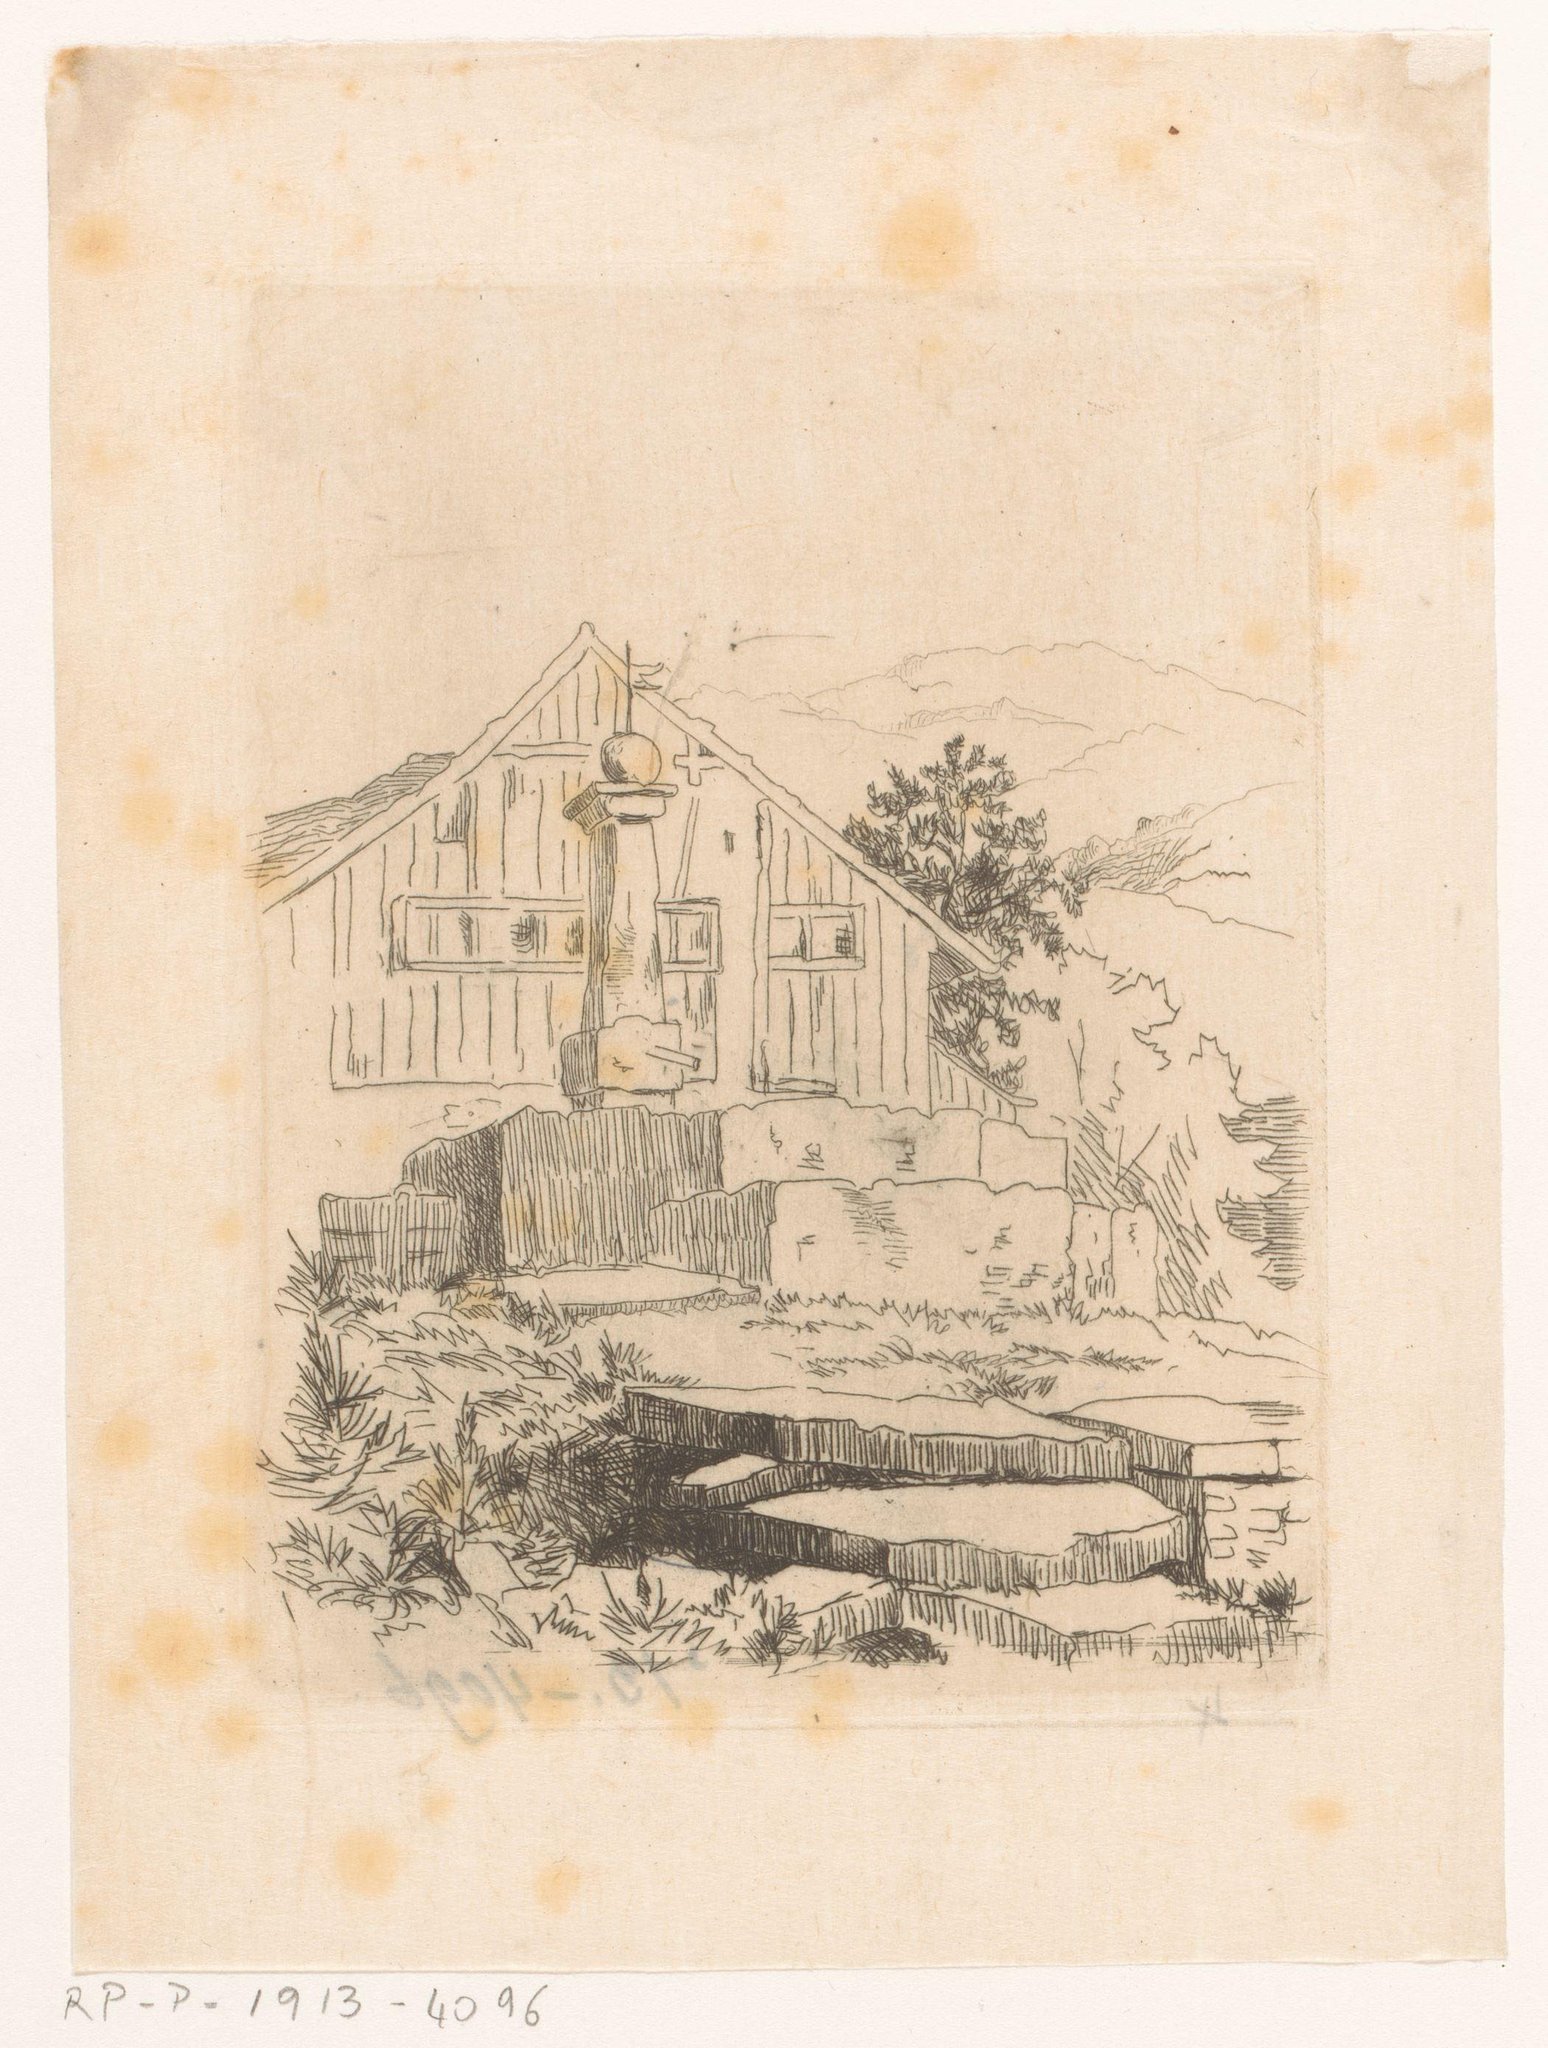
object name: print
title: Houten huis met bron ervoor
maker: maria van hohenzollern-sigmaringen (gravin van vlaanderen)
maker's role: print maker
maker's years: 1845-1912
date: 1868-1912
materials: paper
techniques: etching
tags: well, city-view, and landscape with man-made constructions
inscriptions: collector's mark: Lugt 2228